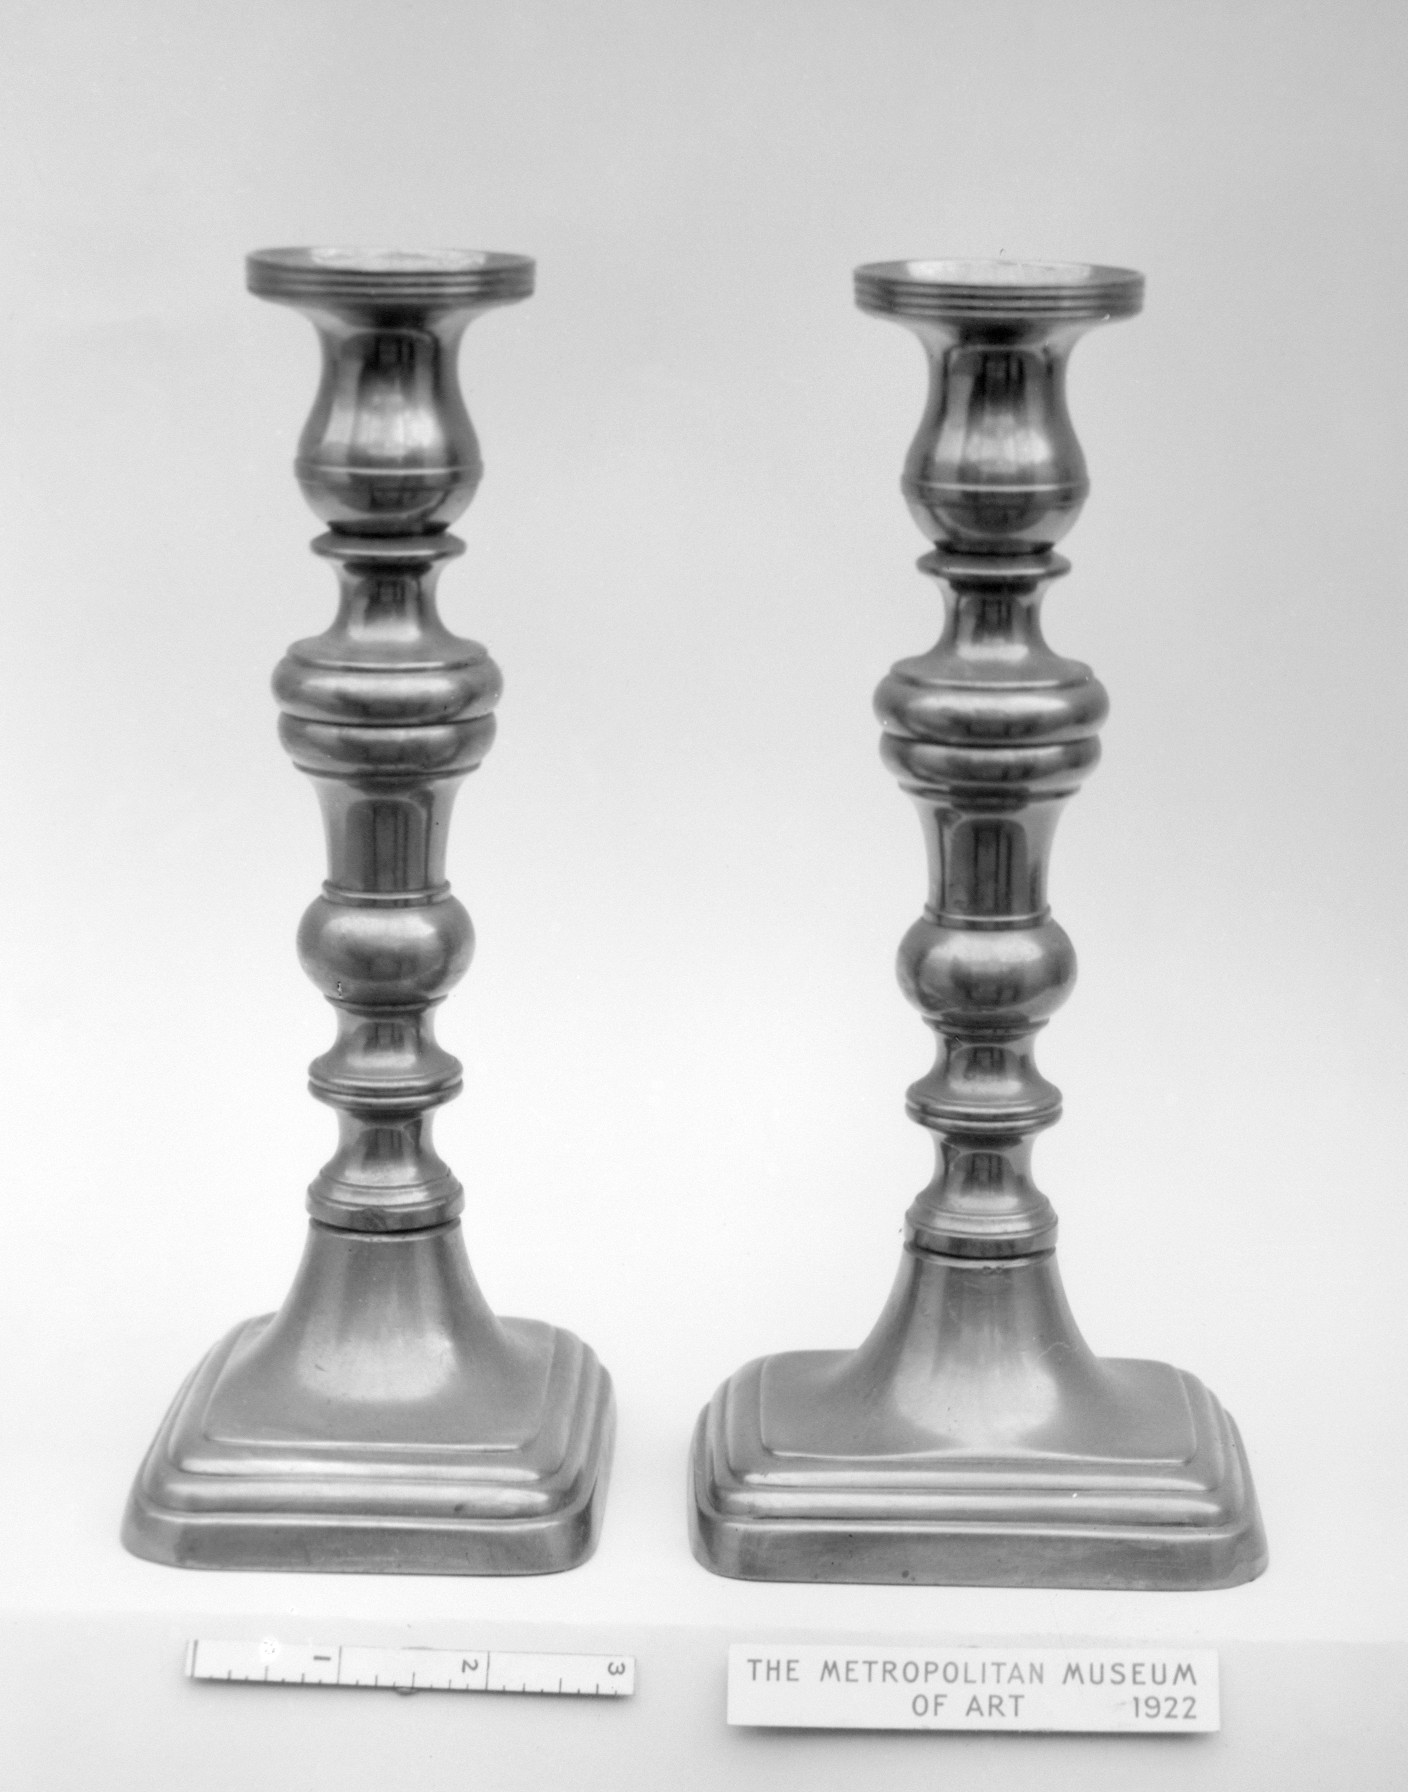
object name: candlestick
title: Pair of candlesticks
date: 1801-1900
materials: brass